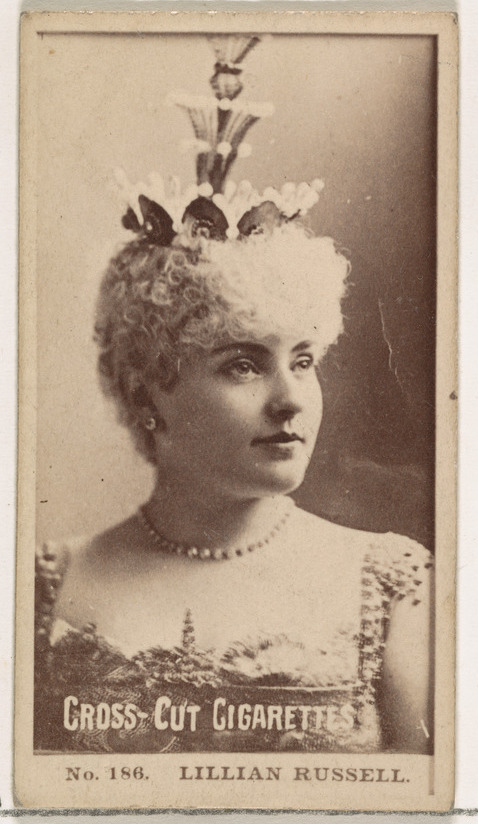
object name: print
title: Card Number 186, Lillian Russell, from the Actors and Actresses series (N145-2) issued by Duke Sons & Co. to promote Cross Cut Cigarettes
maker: w. duke, sons & co.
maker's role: publisher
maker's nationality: american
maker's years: 1870-1920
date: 1880-1889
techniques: albumen silver print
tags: portraits,women,actresses